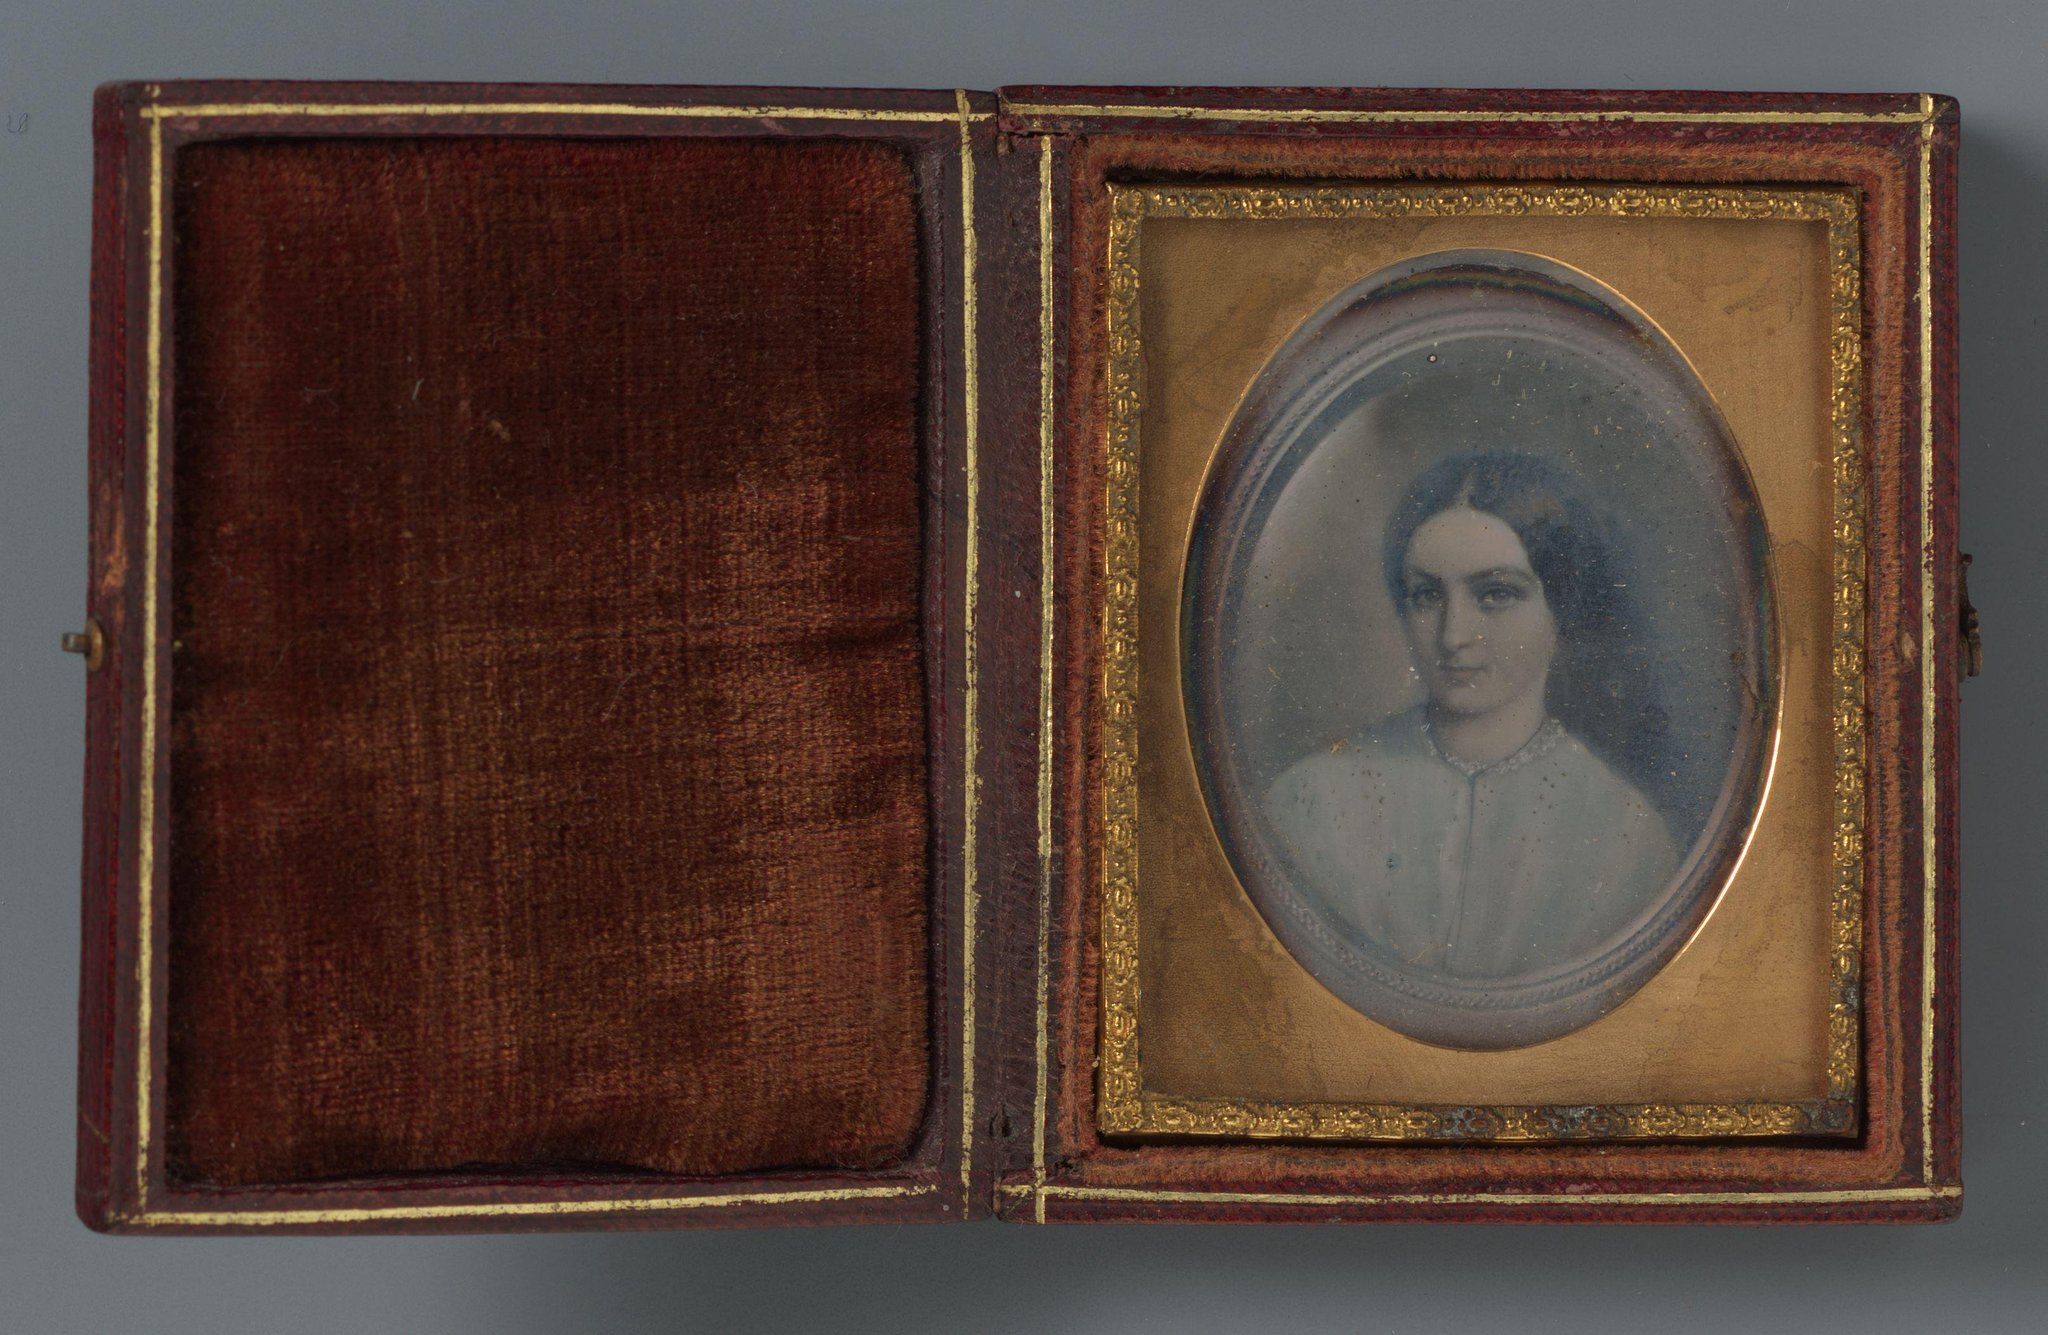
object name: reproduction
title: Fotoreproductie van een portret van Ellen Hope-Copleston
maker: Anonymous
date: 1840-1860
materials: copper, glass, leather, velvet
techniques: daguerreotype, hand coloring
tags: adolescent, young woman, maiden, historical persons, painting, drawing and the graphic arts